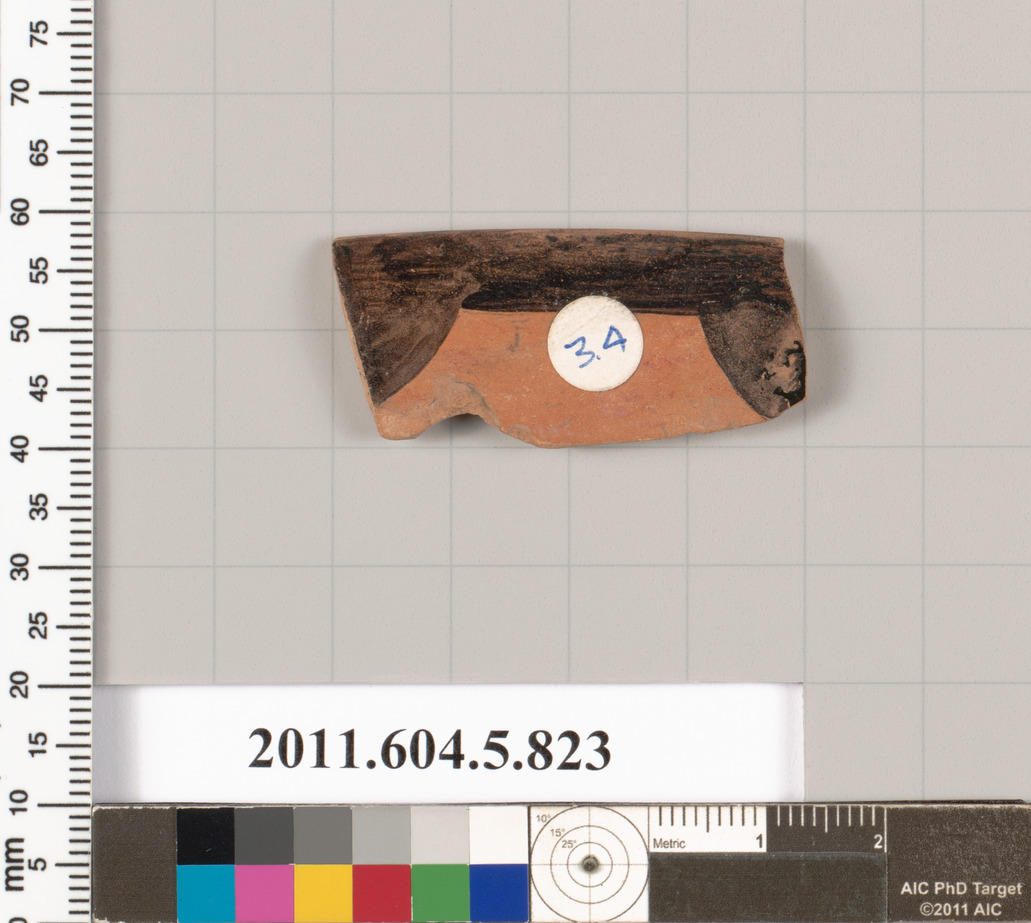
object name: kylix fragment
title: Terracotta rim fragment of a kylix (drinking cup)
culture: greek, attic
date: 600-401 BCE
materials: terracotta